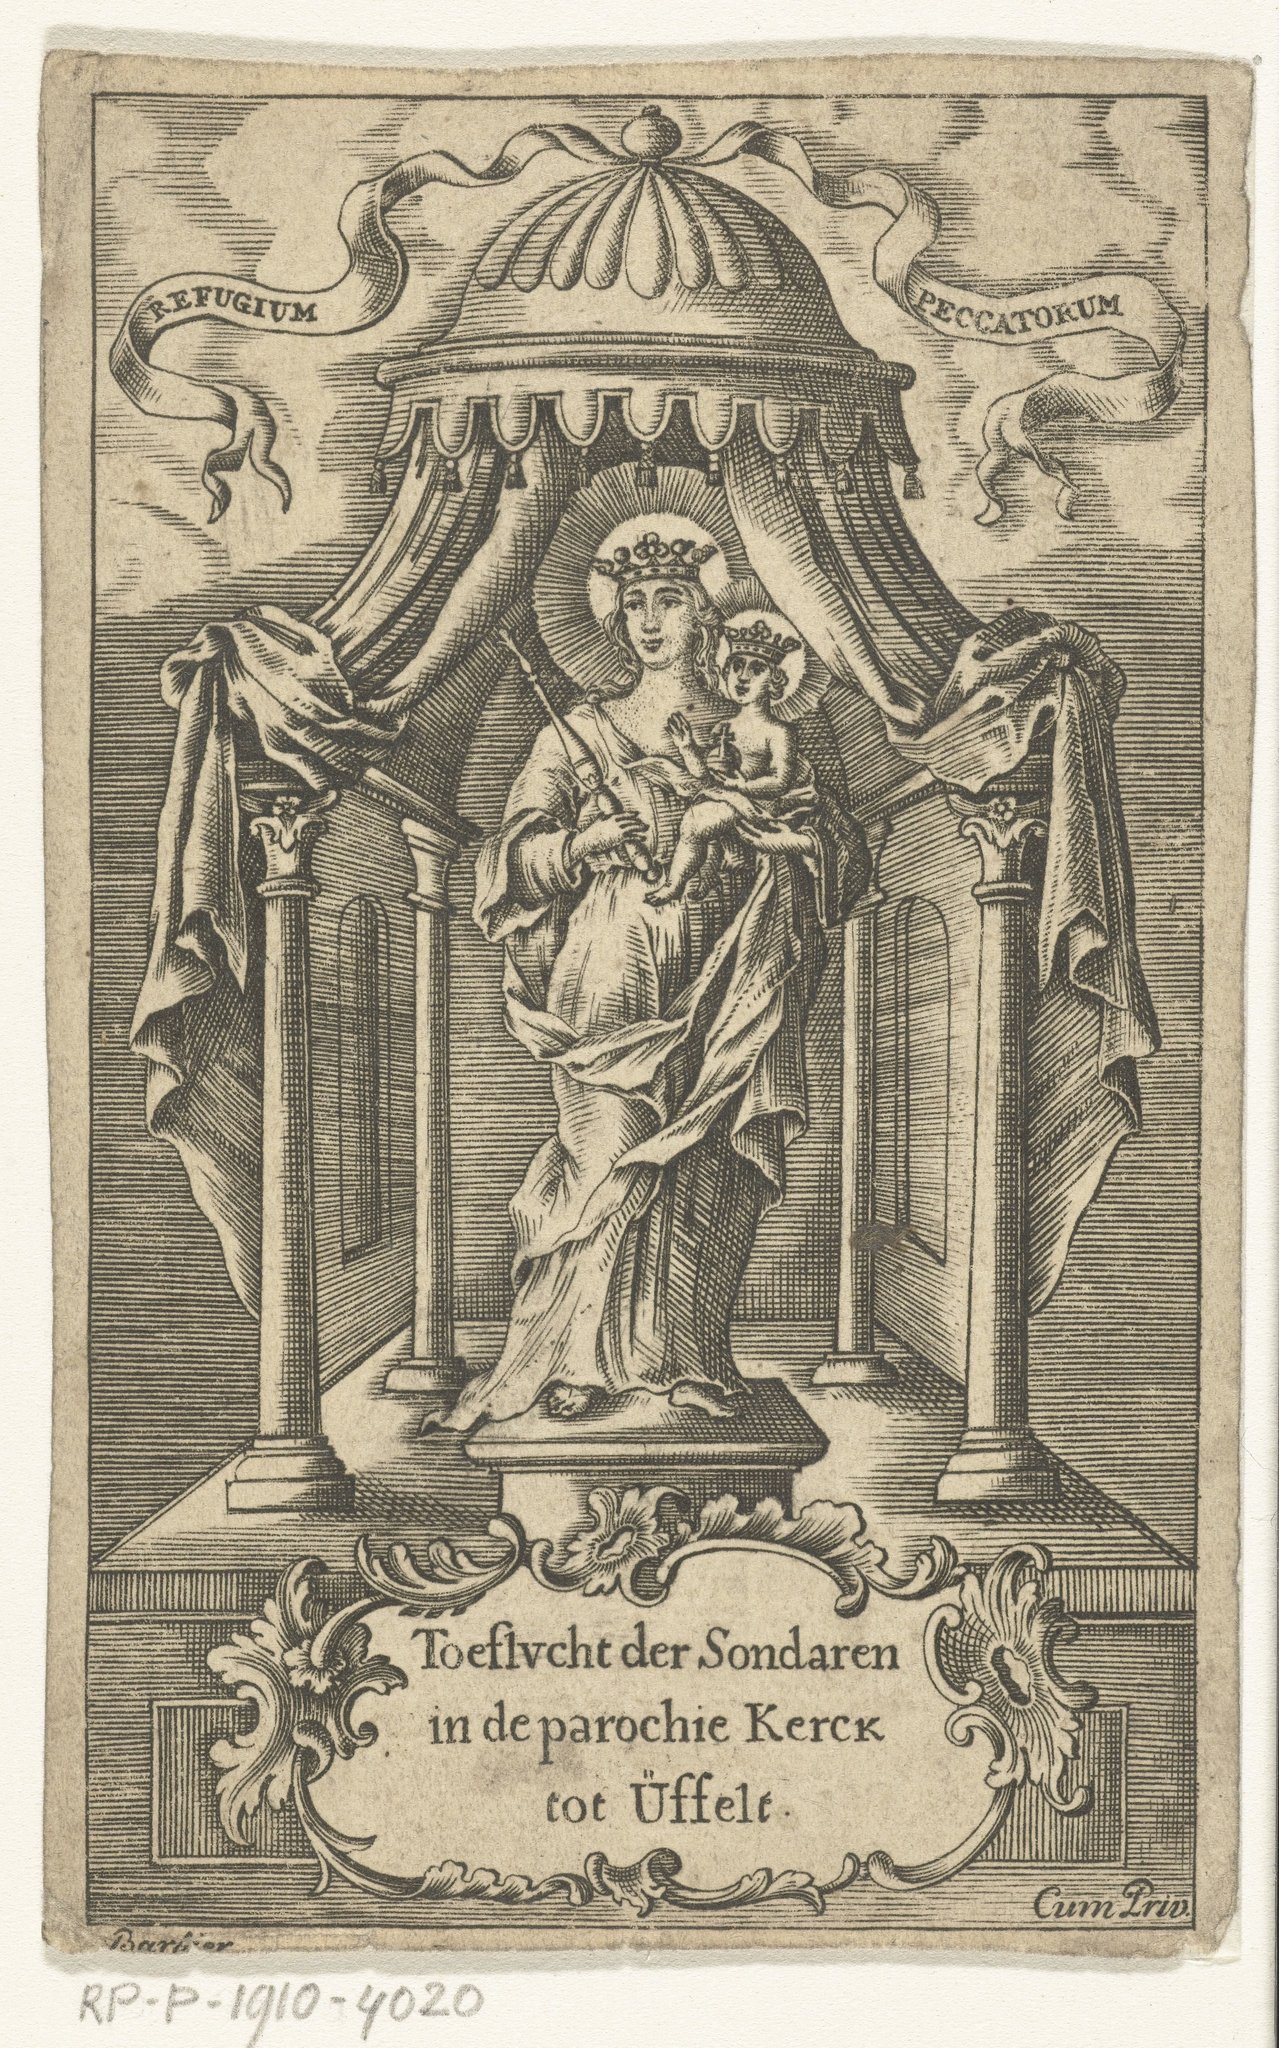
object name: print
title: Genadebeeld van Maria met Kind en scepter staand onder baldakijn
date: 1753-1799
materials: paper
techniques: engraving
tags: miraculous statues of mary or the madonna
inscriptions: collector's mark: Lugt 2228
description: Prent naar genadebeeld van Maria, toevlucht der zondaren dat vanaf 1753 tot 1944 in de kerk te Oeffelt stond en verantwoordelijk was voor wonderen.